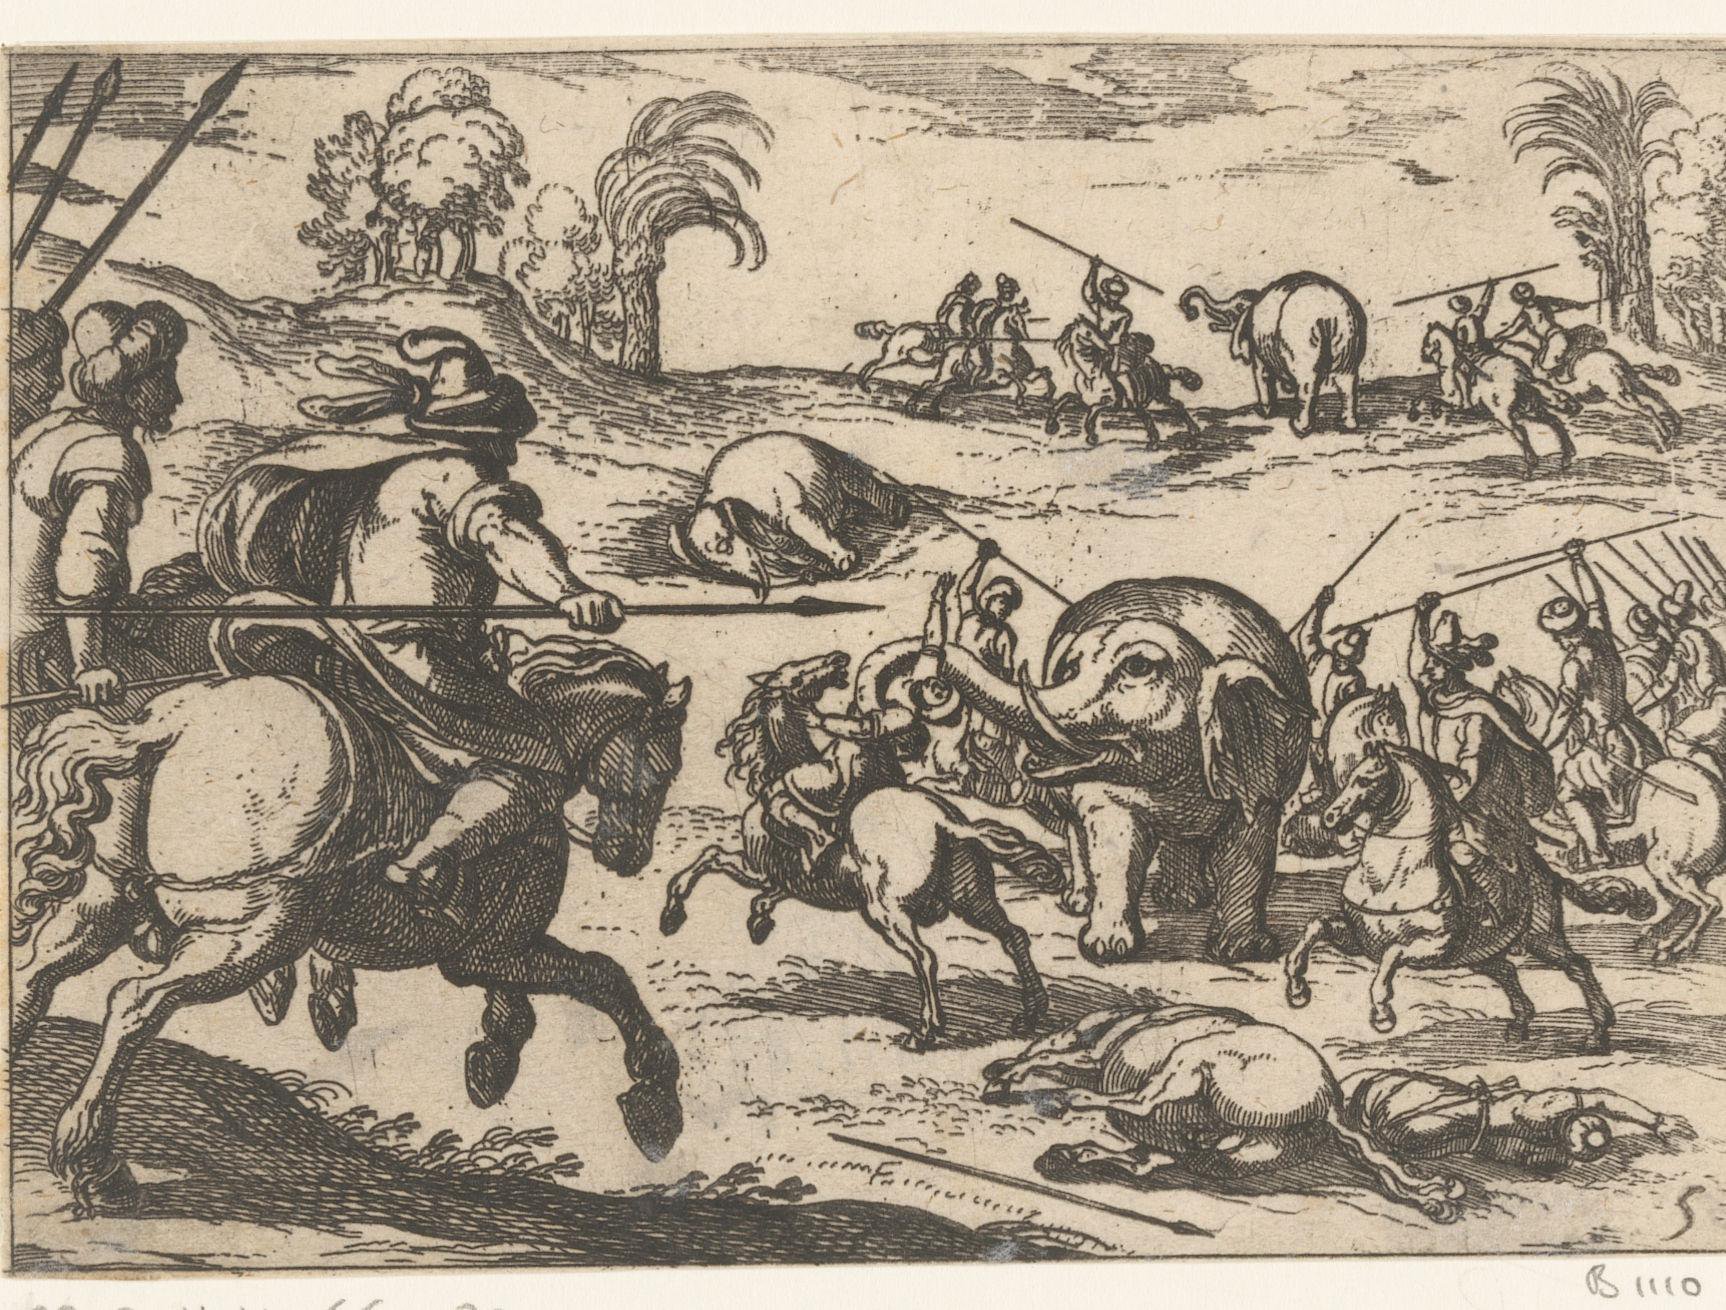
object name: print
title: Jacht op olifanten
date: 1598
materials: paper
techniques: etching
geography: vatican city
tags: hunter, hunters hunting (n.b.: in 1988-1990 this notation denoted the concept of 43c11421 'hunters resting during the hunt'), trunked animals: elephant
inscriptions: collector's mark: ‘Hinloopen’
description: Deze prent maakt deel uit van een reeks van vijftien prenten met jachtscènes (+ opdracht).